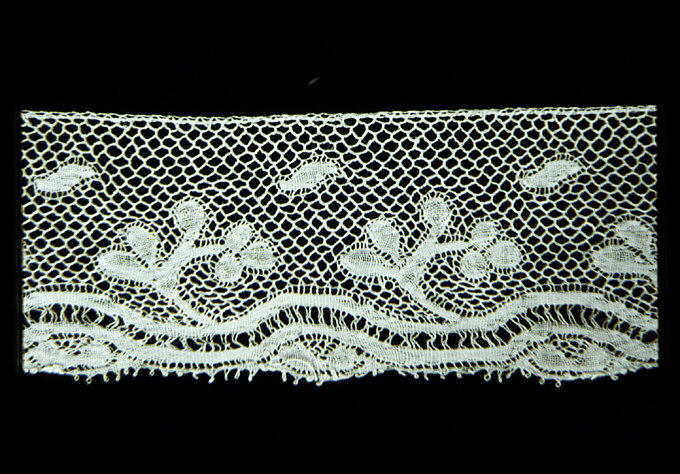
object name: strip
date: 1801-1900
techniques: lace